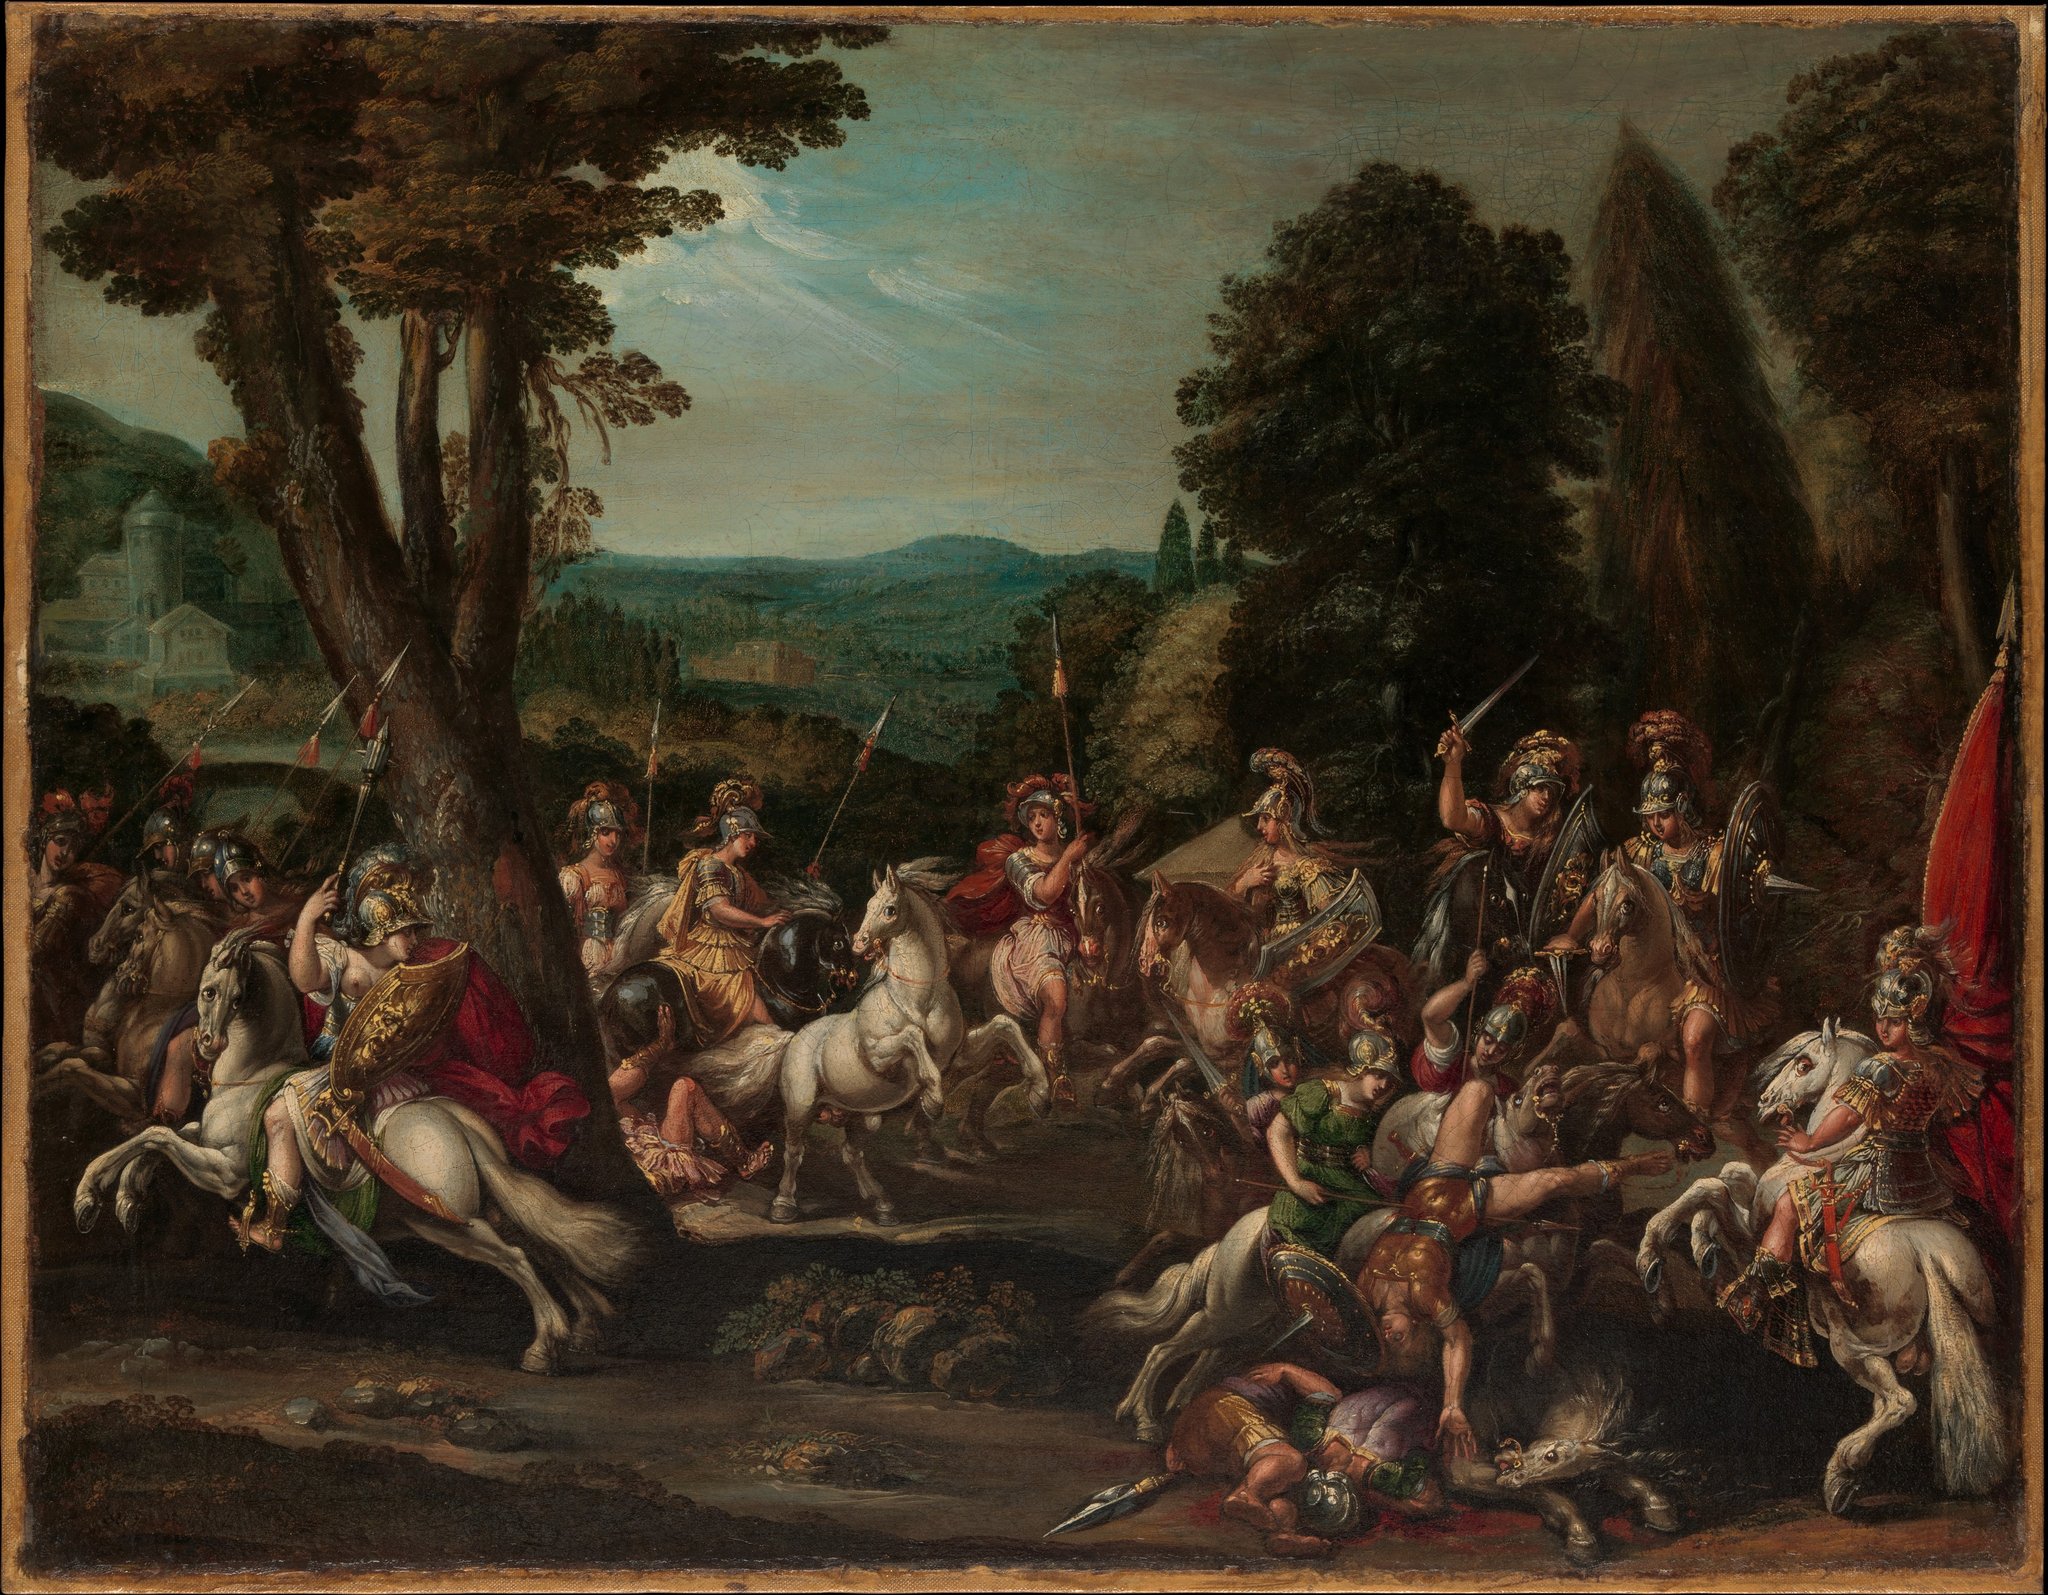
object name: painting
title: Triumph of the Amazons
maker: claude déruet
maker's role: artist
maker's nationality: french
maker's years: 1583-1660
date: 1620-1629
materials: canvas, oil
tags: battles,soldiers,women,horses